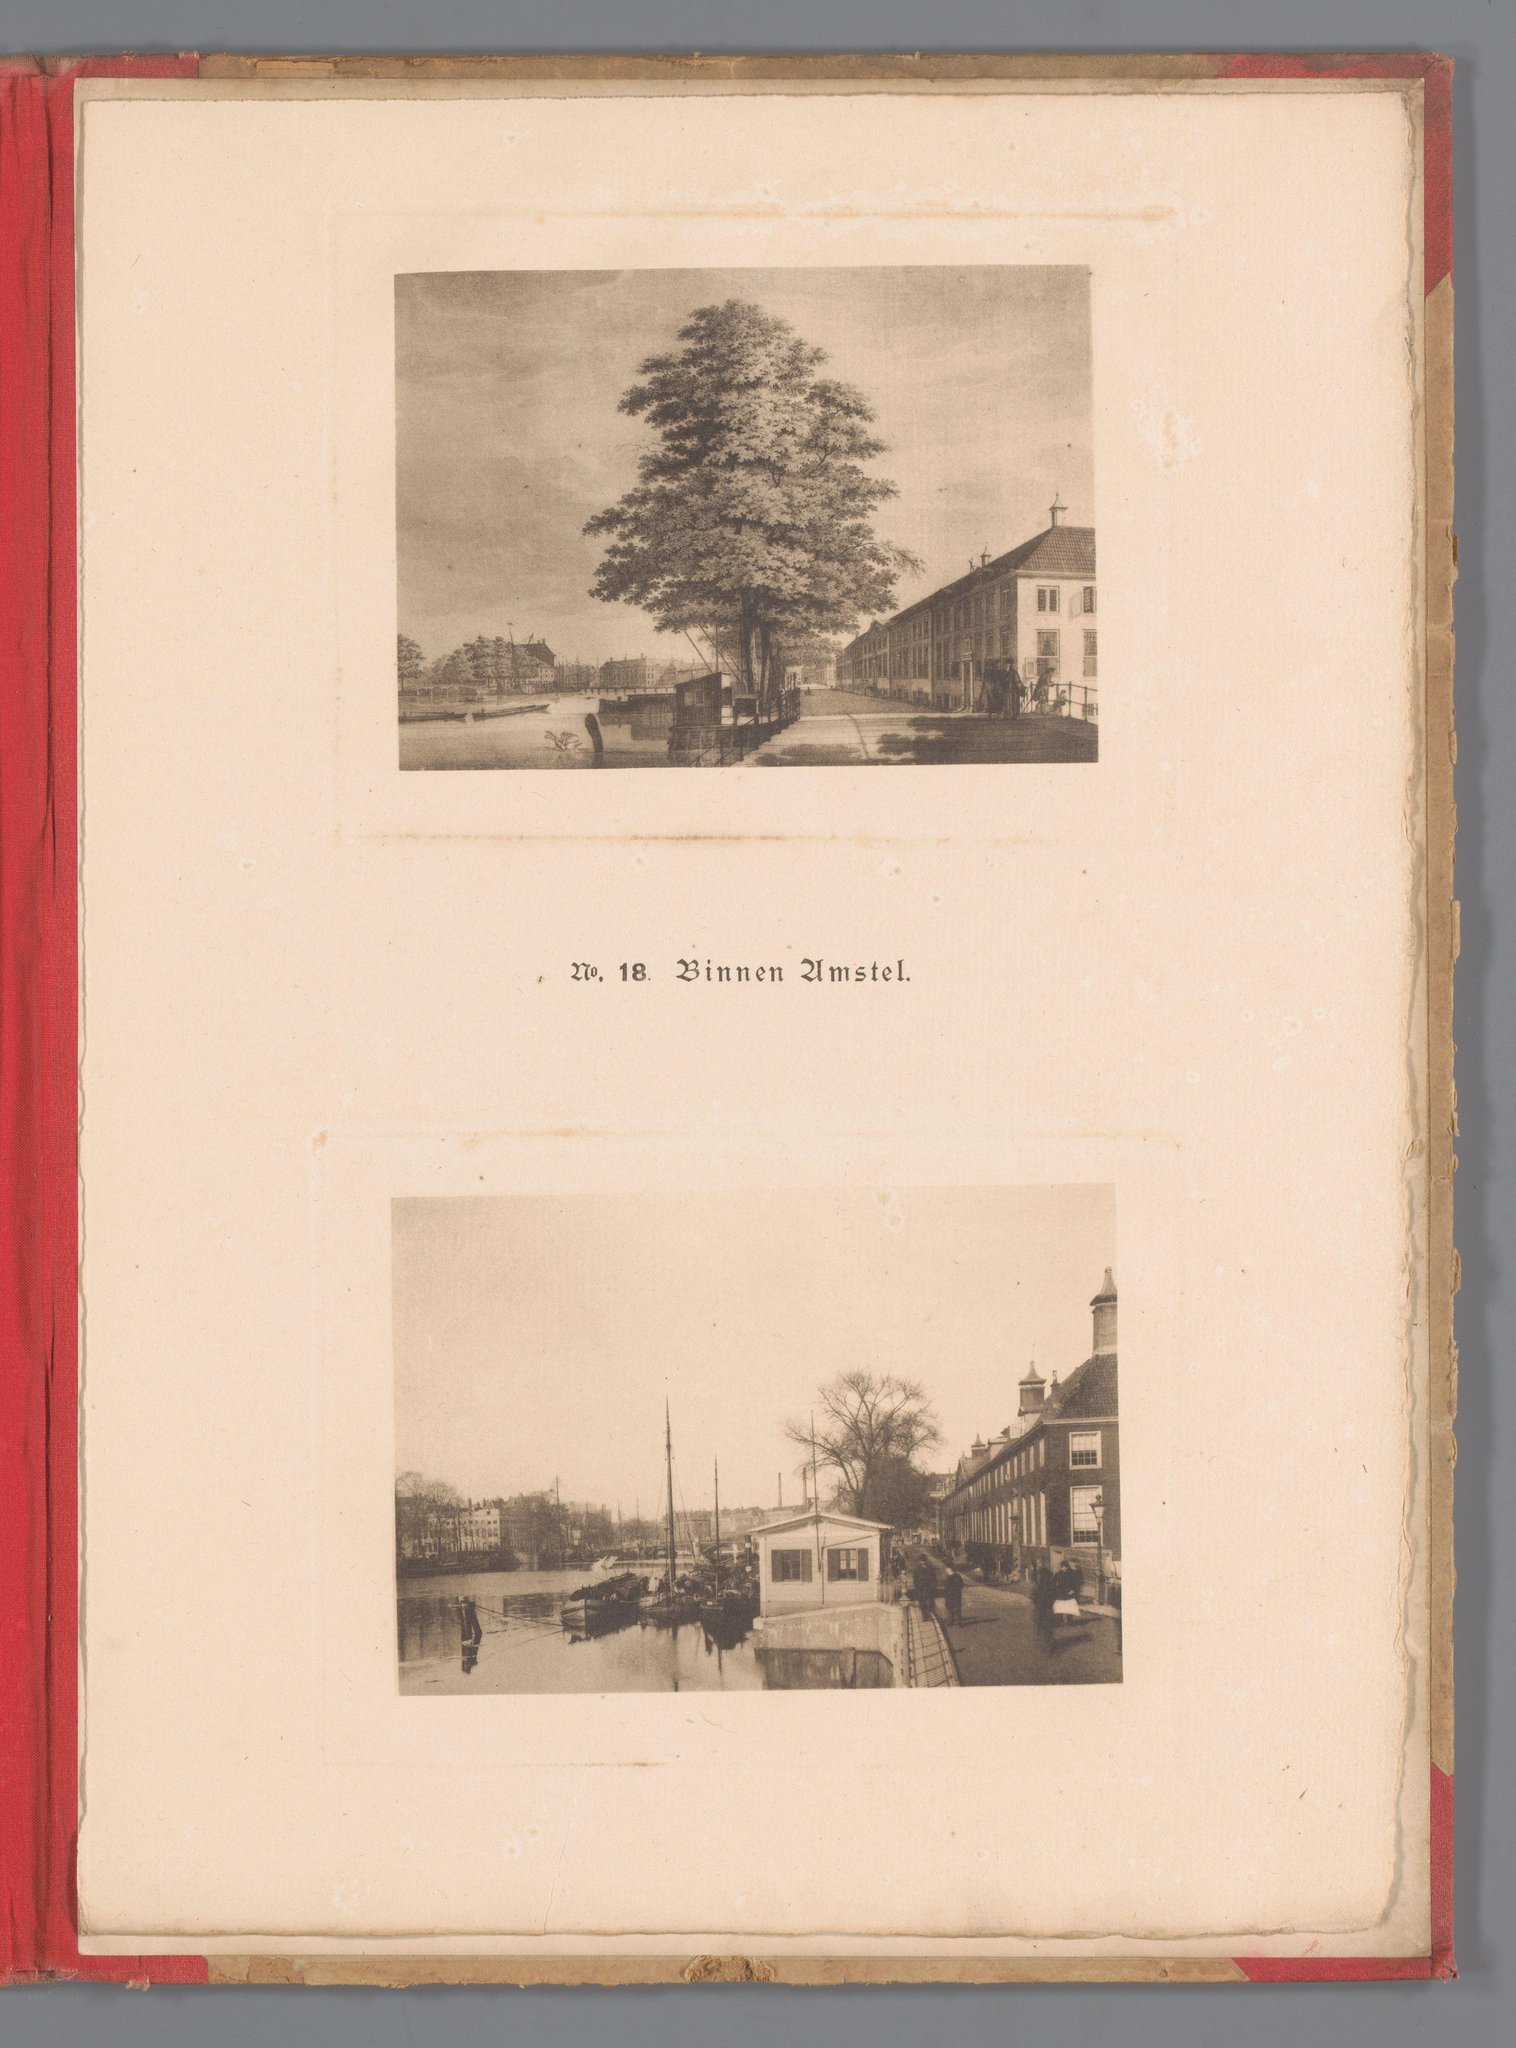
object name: photomechanical print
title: Twee gezichten op het Diaconie Oude Vrouwen- en Mannenhuis, waarvan één reproductie van een prent door Caspar Jacobsz. Philips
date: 1890-1900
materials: paper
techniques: photograph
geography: amsterdam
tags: canals, waters (in city) (+ city(-scape) with figures, staffage), old-people's home, street (+ city(-scape) with figures, staffage)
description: Deze prenten maken deel uit van een album.